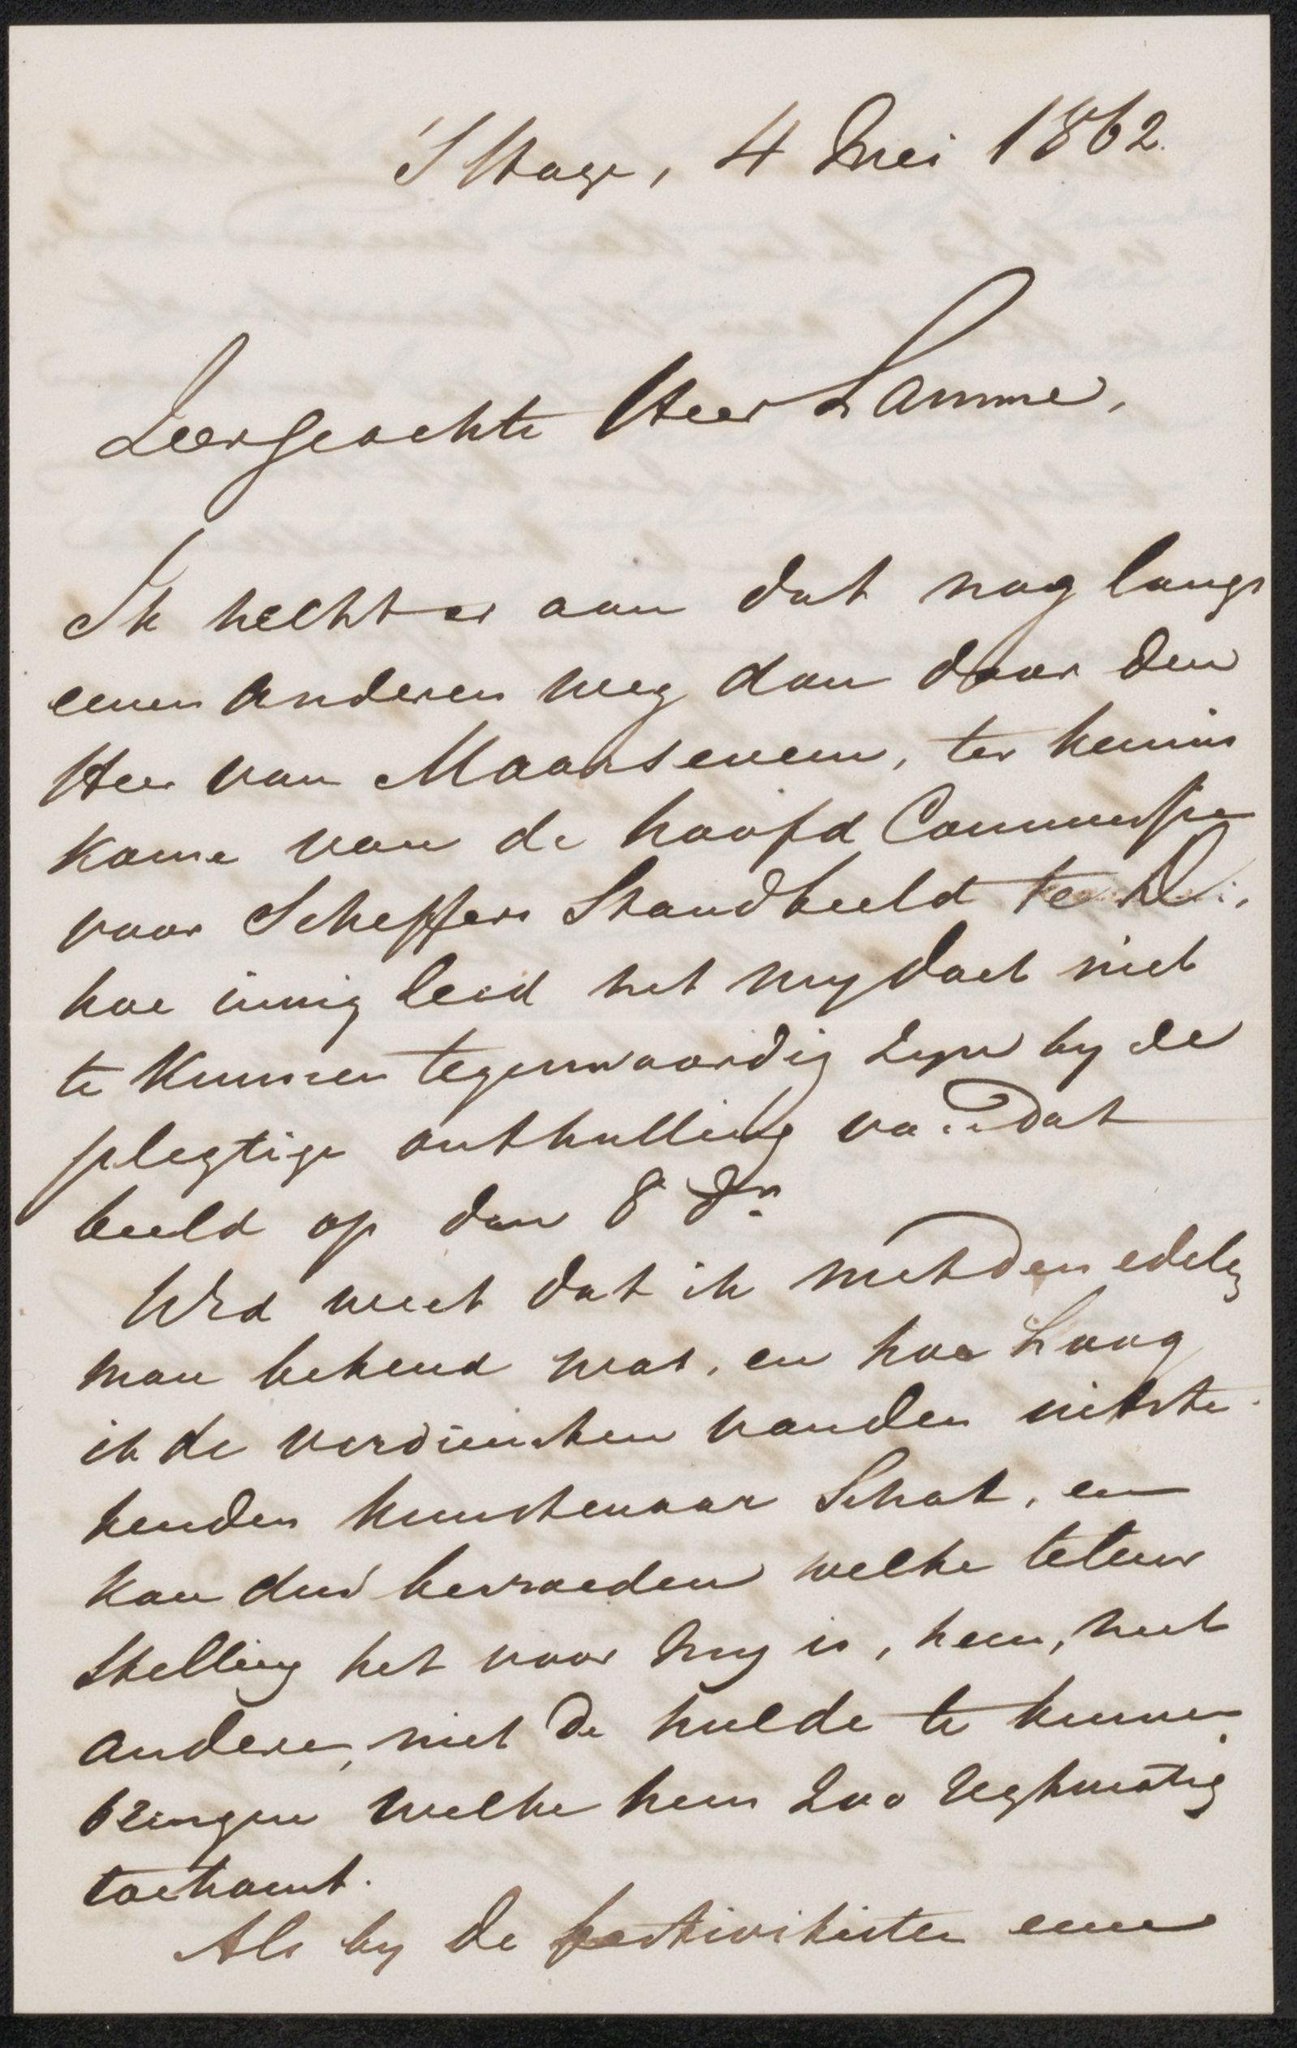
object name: letter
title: Brief aan Ary Johannes Lamme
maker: jean zacherie mazel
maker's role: draughtsman, print maker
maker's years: 1792-1884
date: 1862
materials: ink, paper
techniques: pen, writing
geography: the hague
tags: dordrecht, painter, print maker, draughtsman, sculptor, ary scheffer, ary johannes lamme, sculpture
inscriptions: collector's mark: Lugt 2228